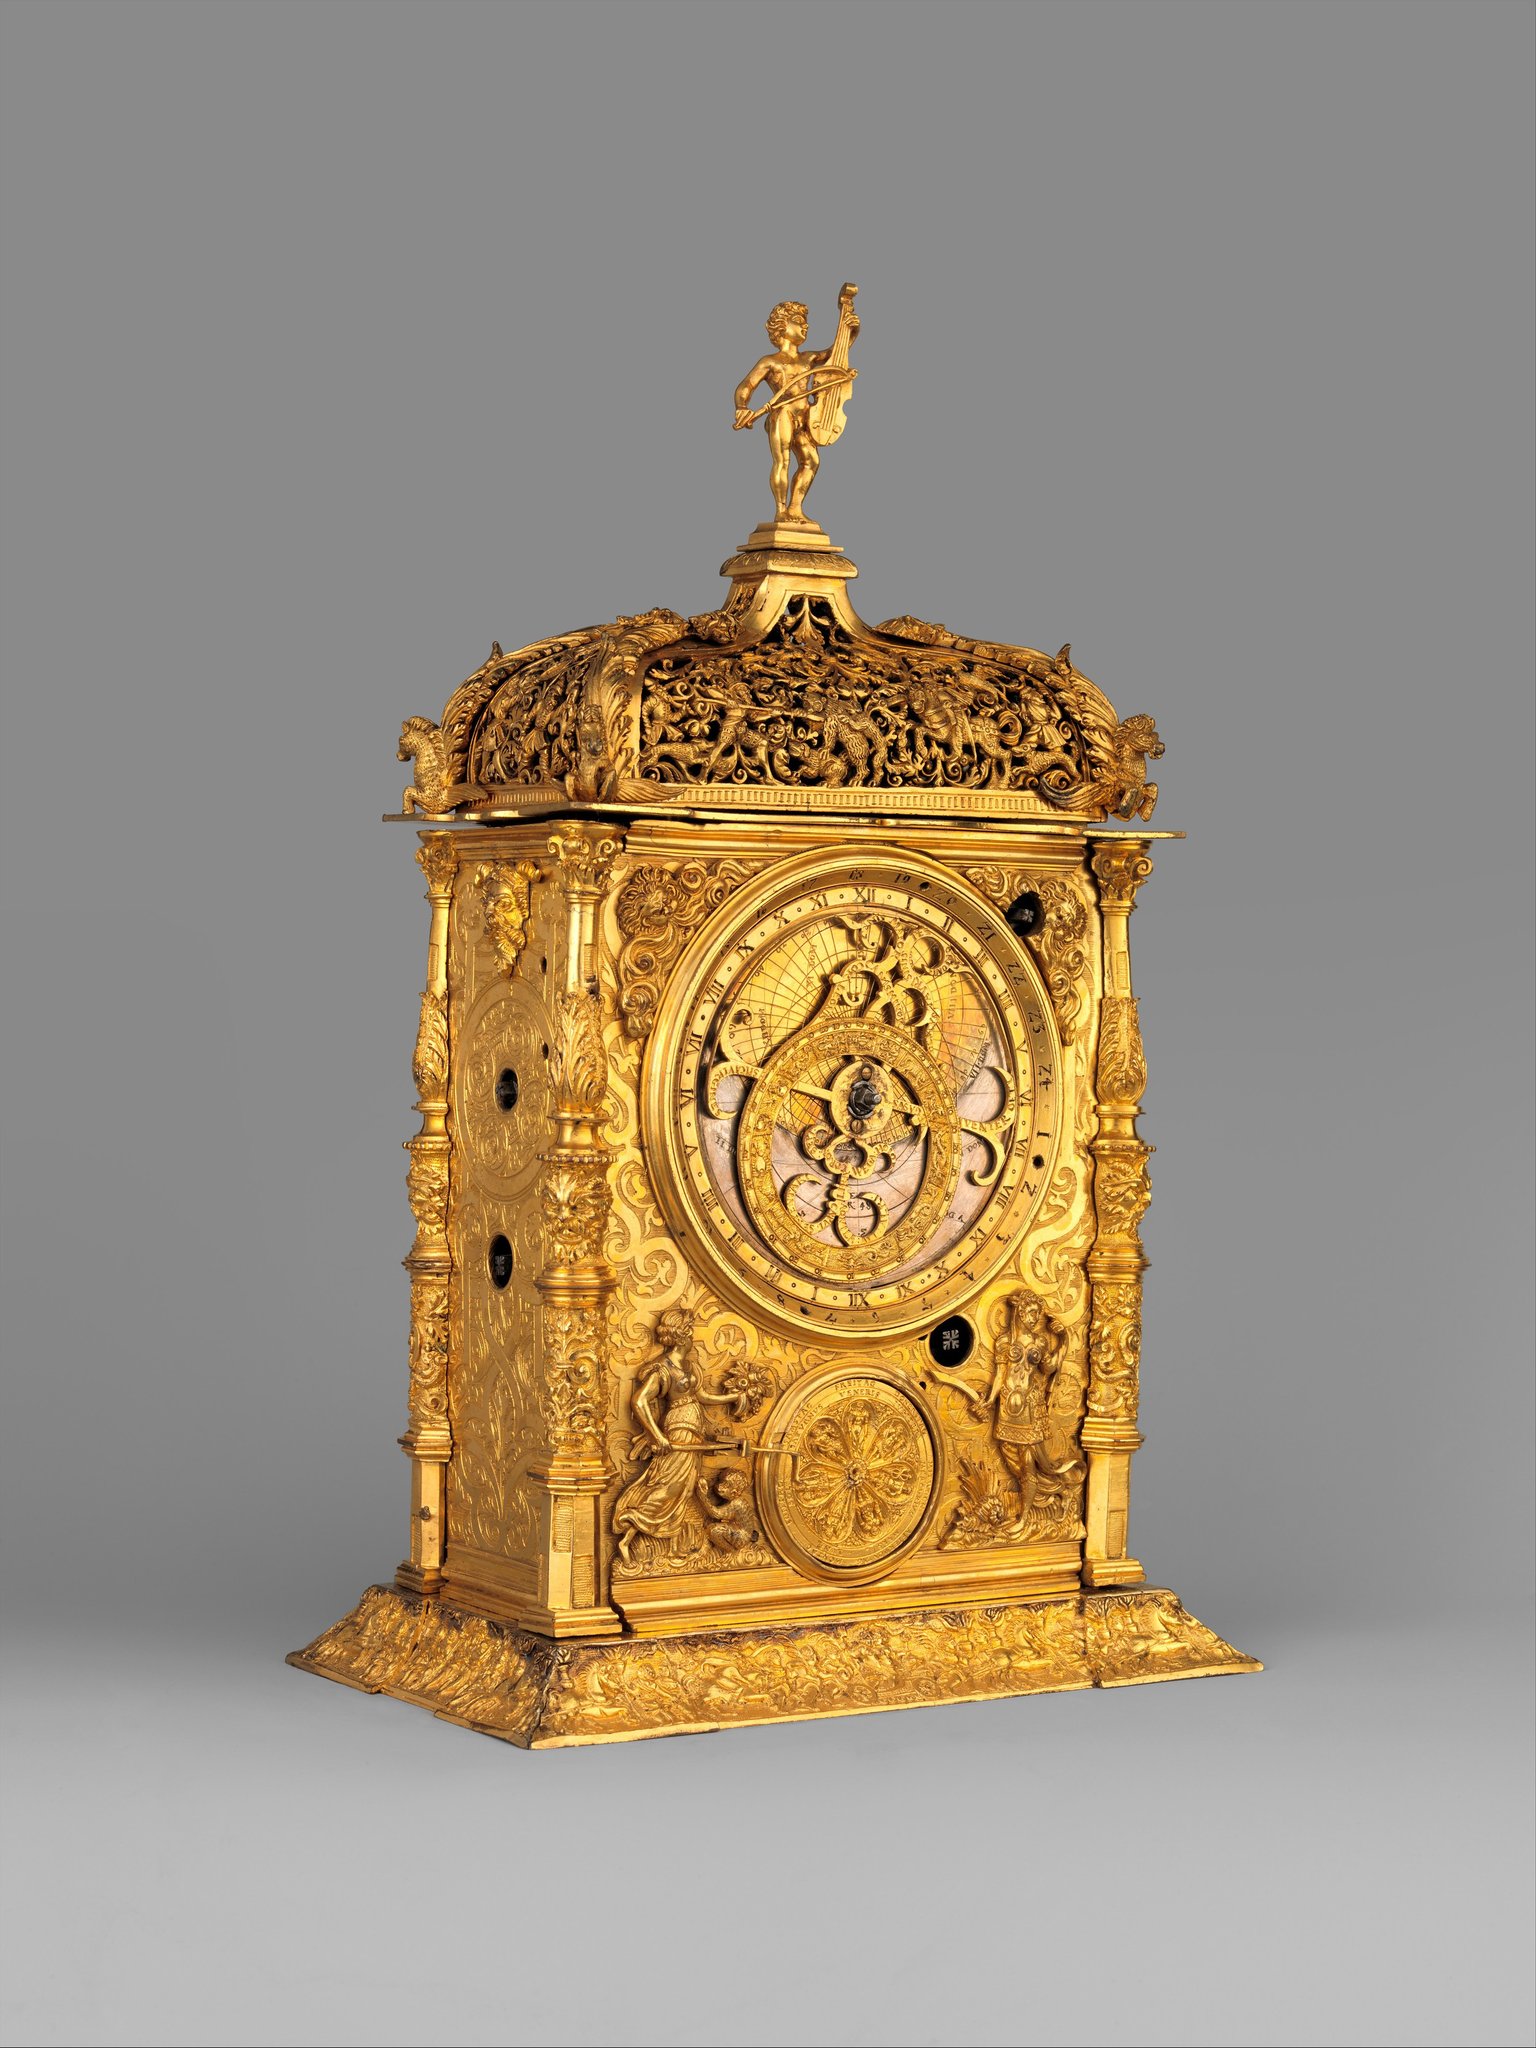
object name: astronomical table clock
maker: jeremias metzger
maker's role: maker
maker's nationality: german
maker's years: 1520-1602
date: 1568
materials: gilt brass, iron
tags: male nudes,pegasus,zodiac